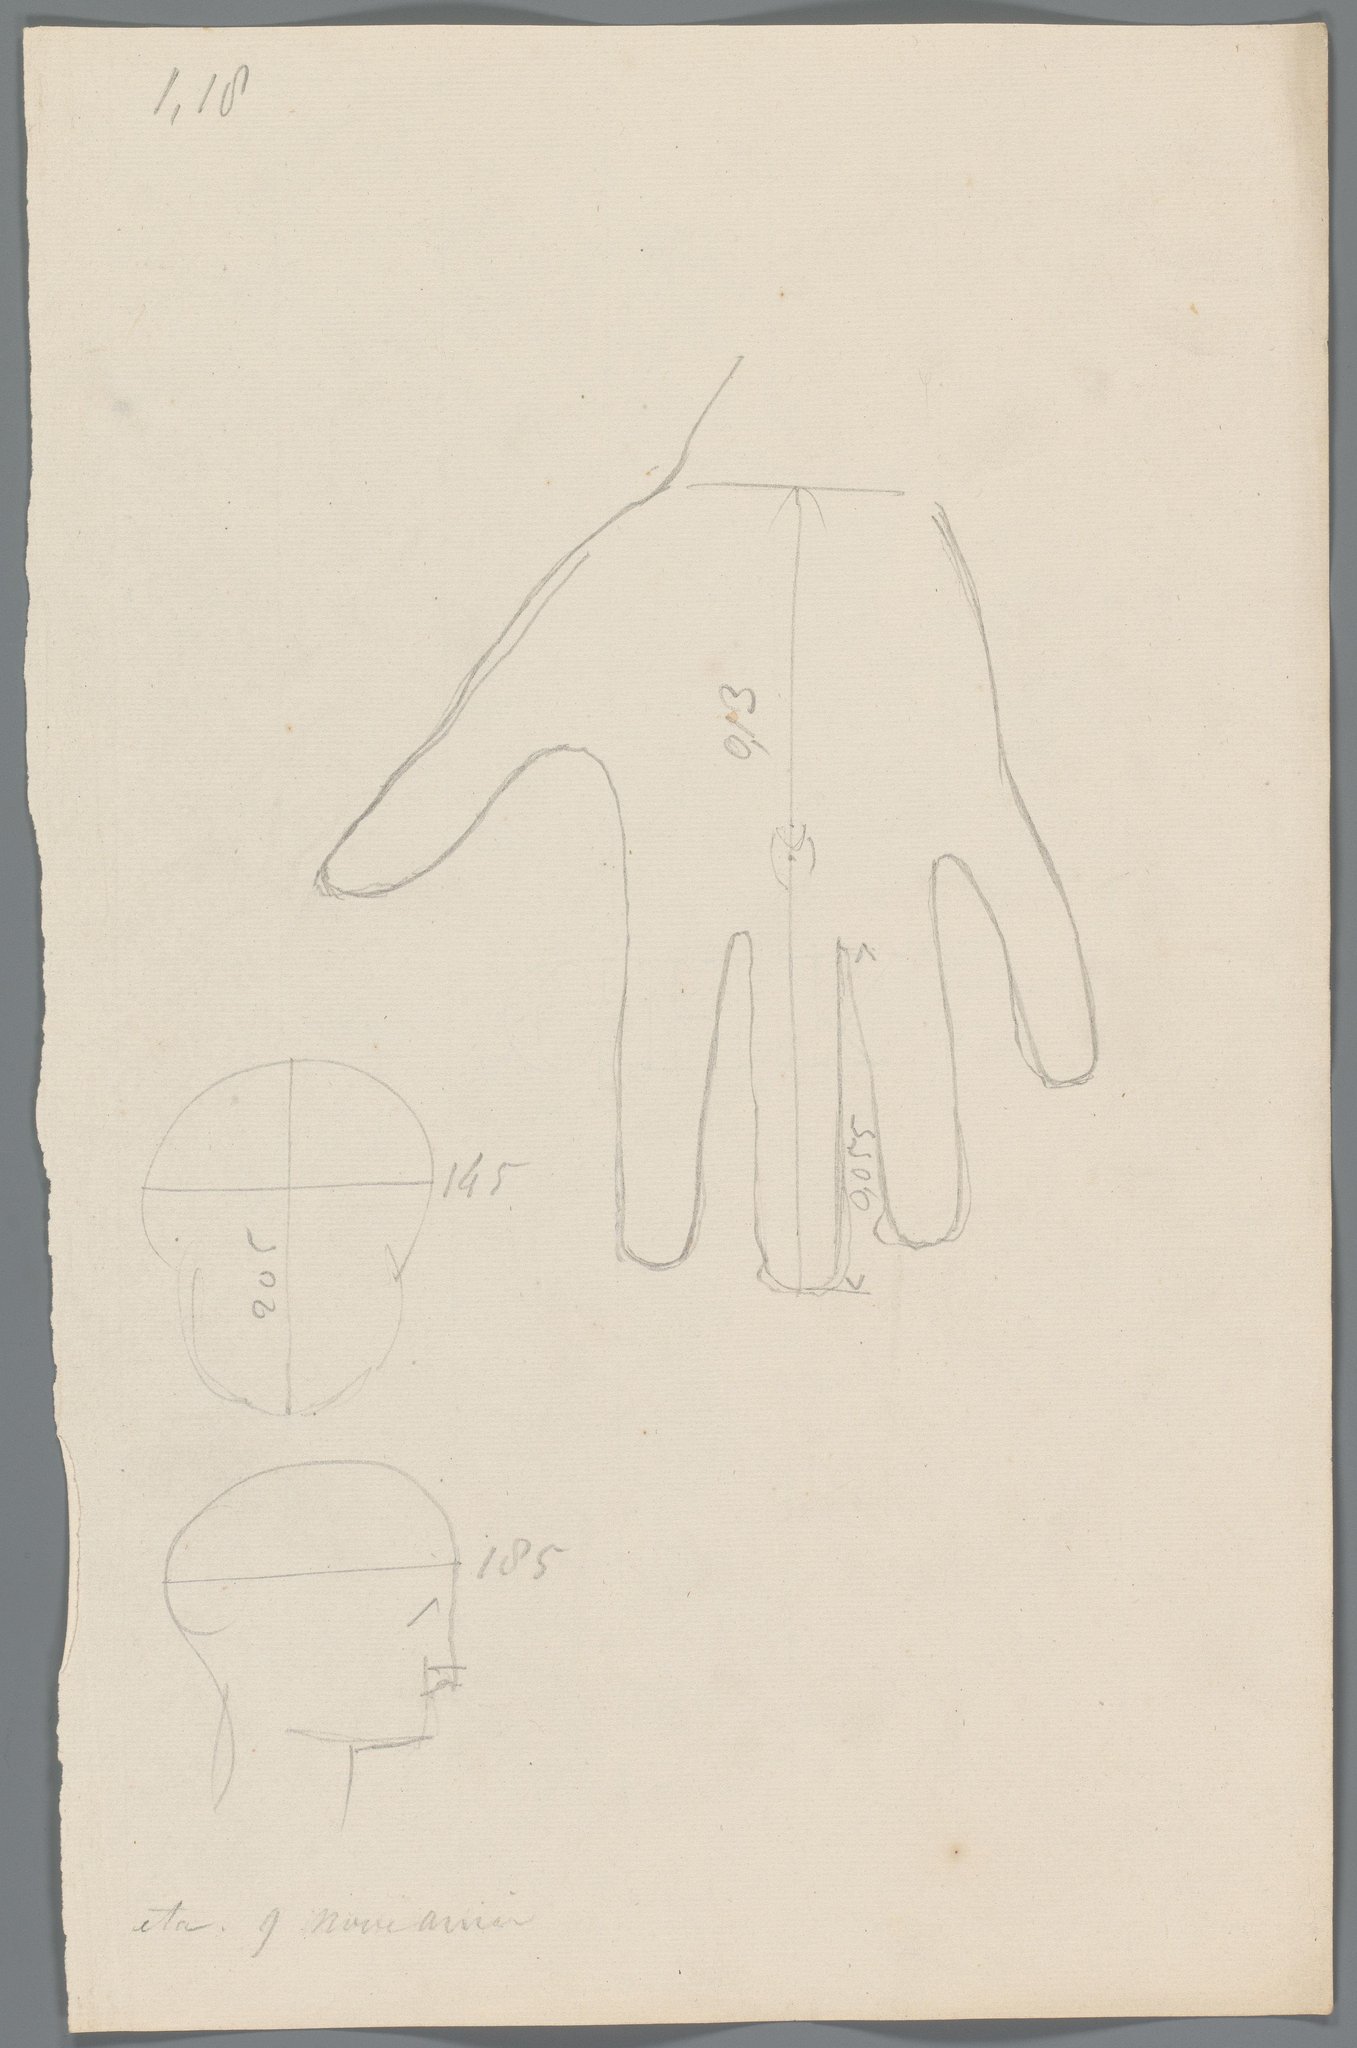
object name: drawing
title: Omtrek van een hand en studie van een hoofd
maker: jacobus everhardus josephus van den berg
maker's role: draughtsman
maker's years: 1802-1861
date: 1812-1861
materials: paper, pencil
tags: postures and gestures of arms and hands in general, postures of the head